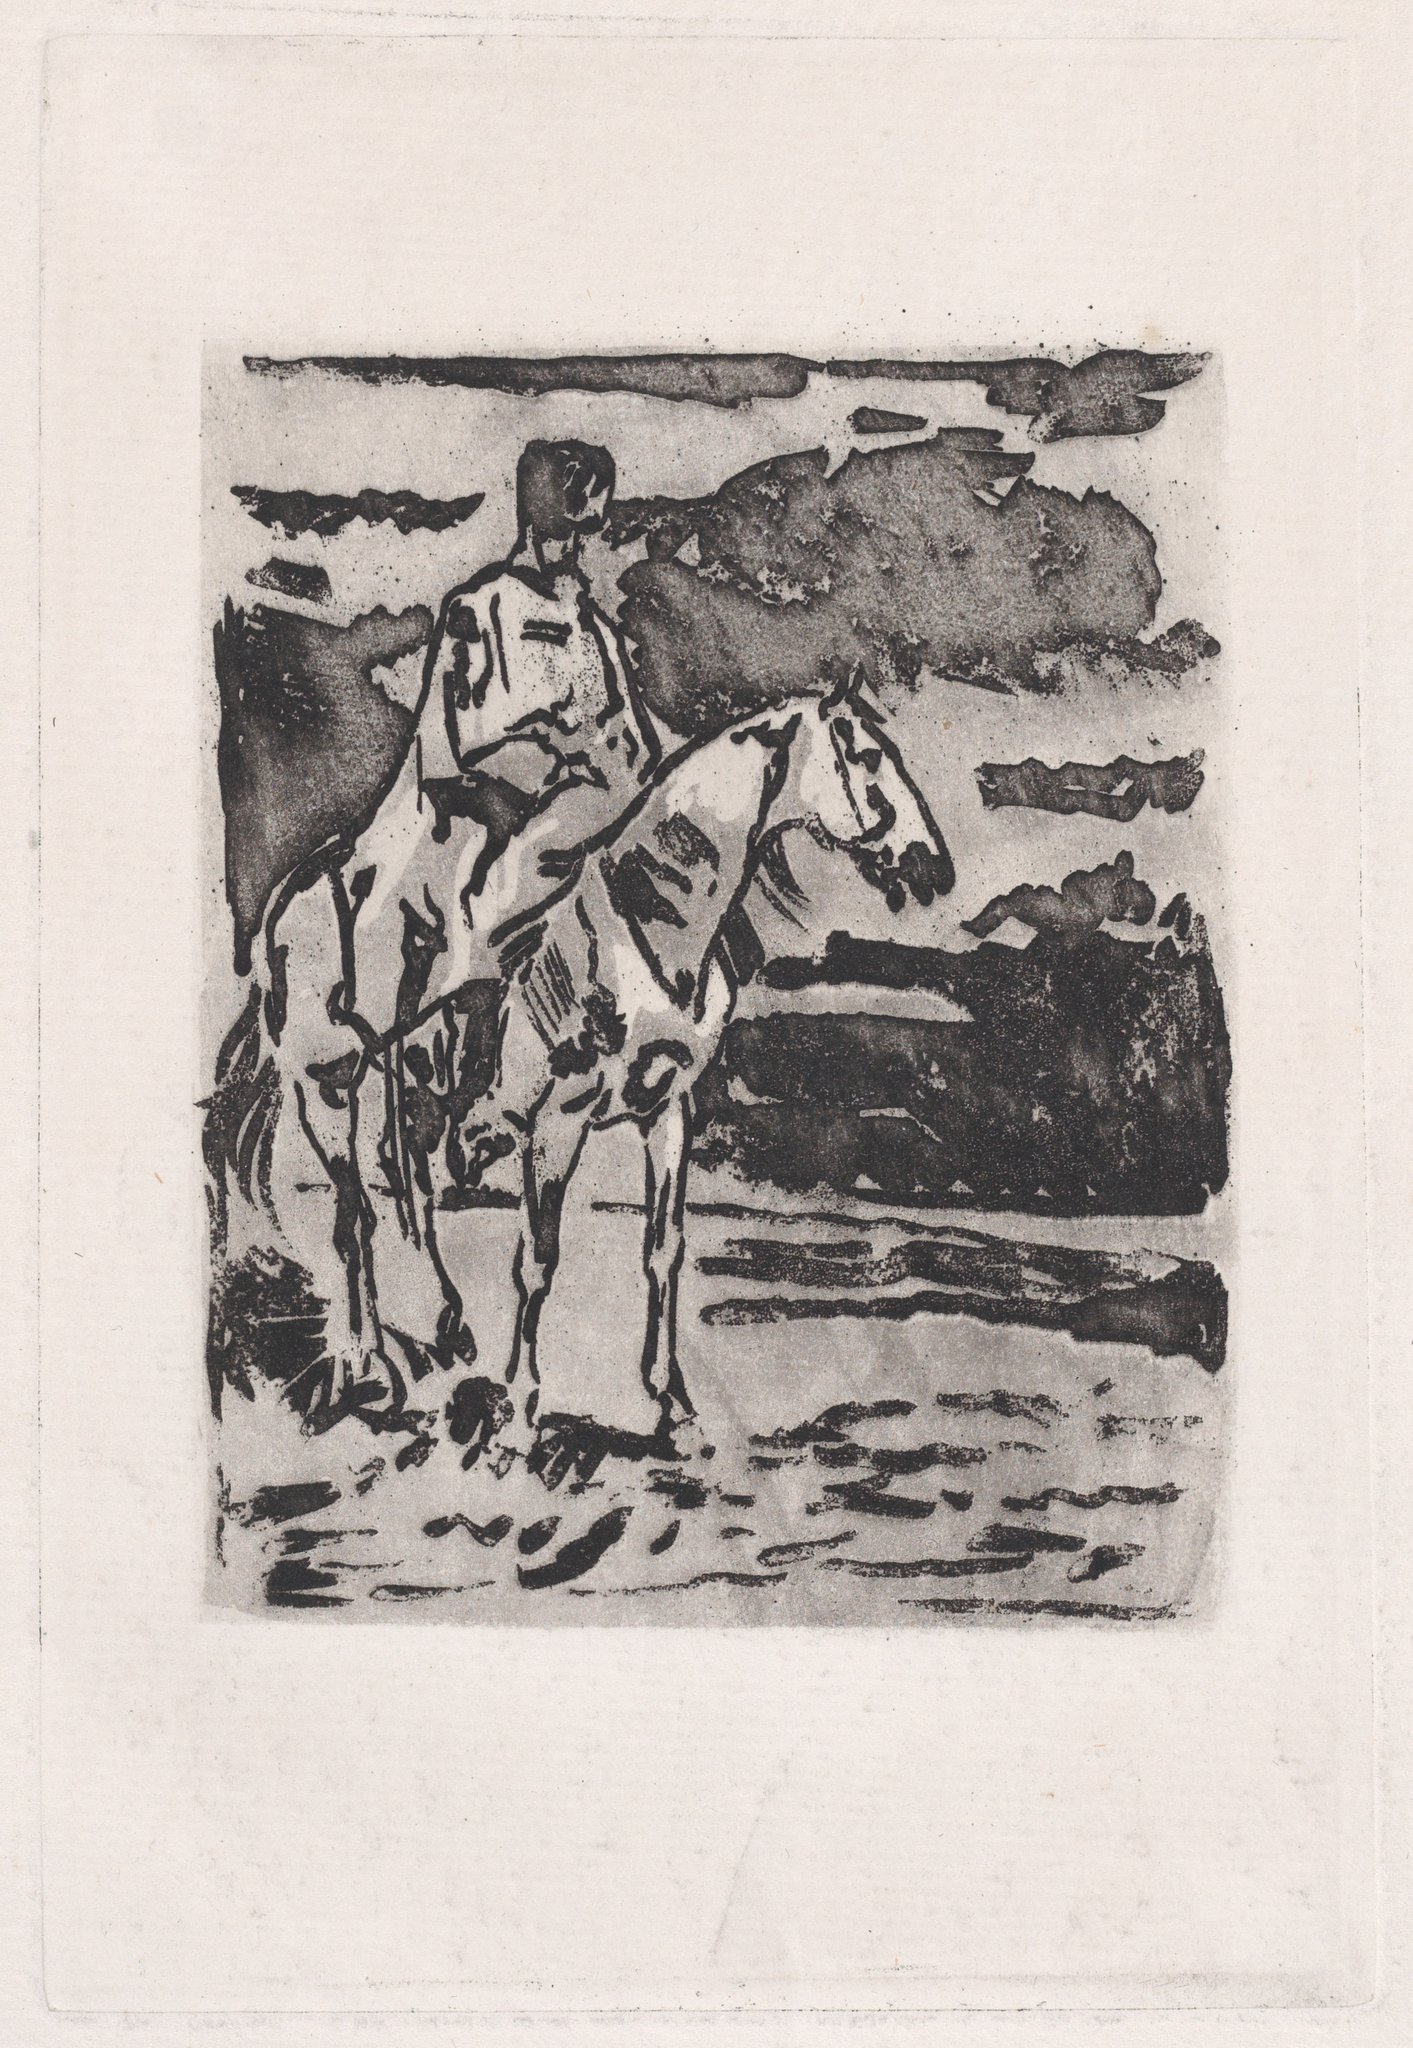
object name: print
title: Hussard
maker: john-lewis brown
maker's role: artist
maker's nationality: french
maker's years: 1829-1890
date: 1801-1900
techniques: aquatint